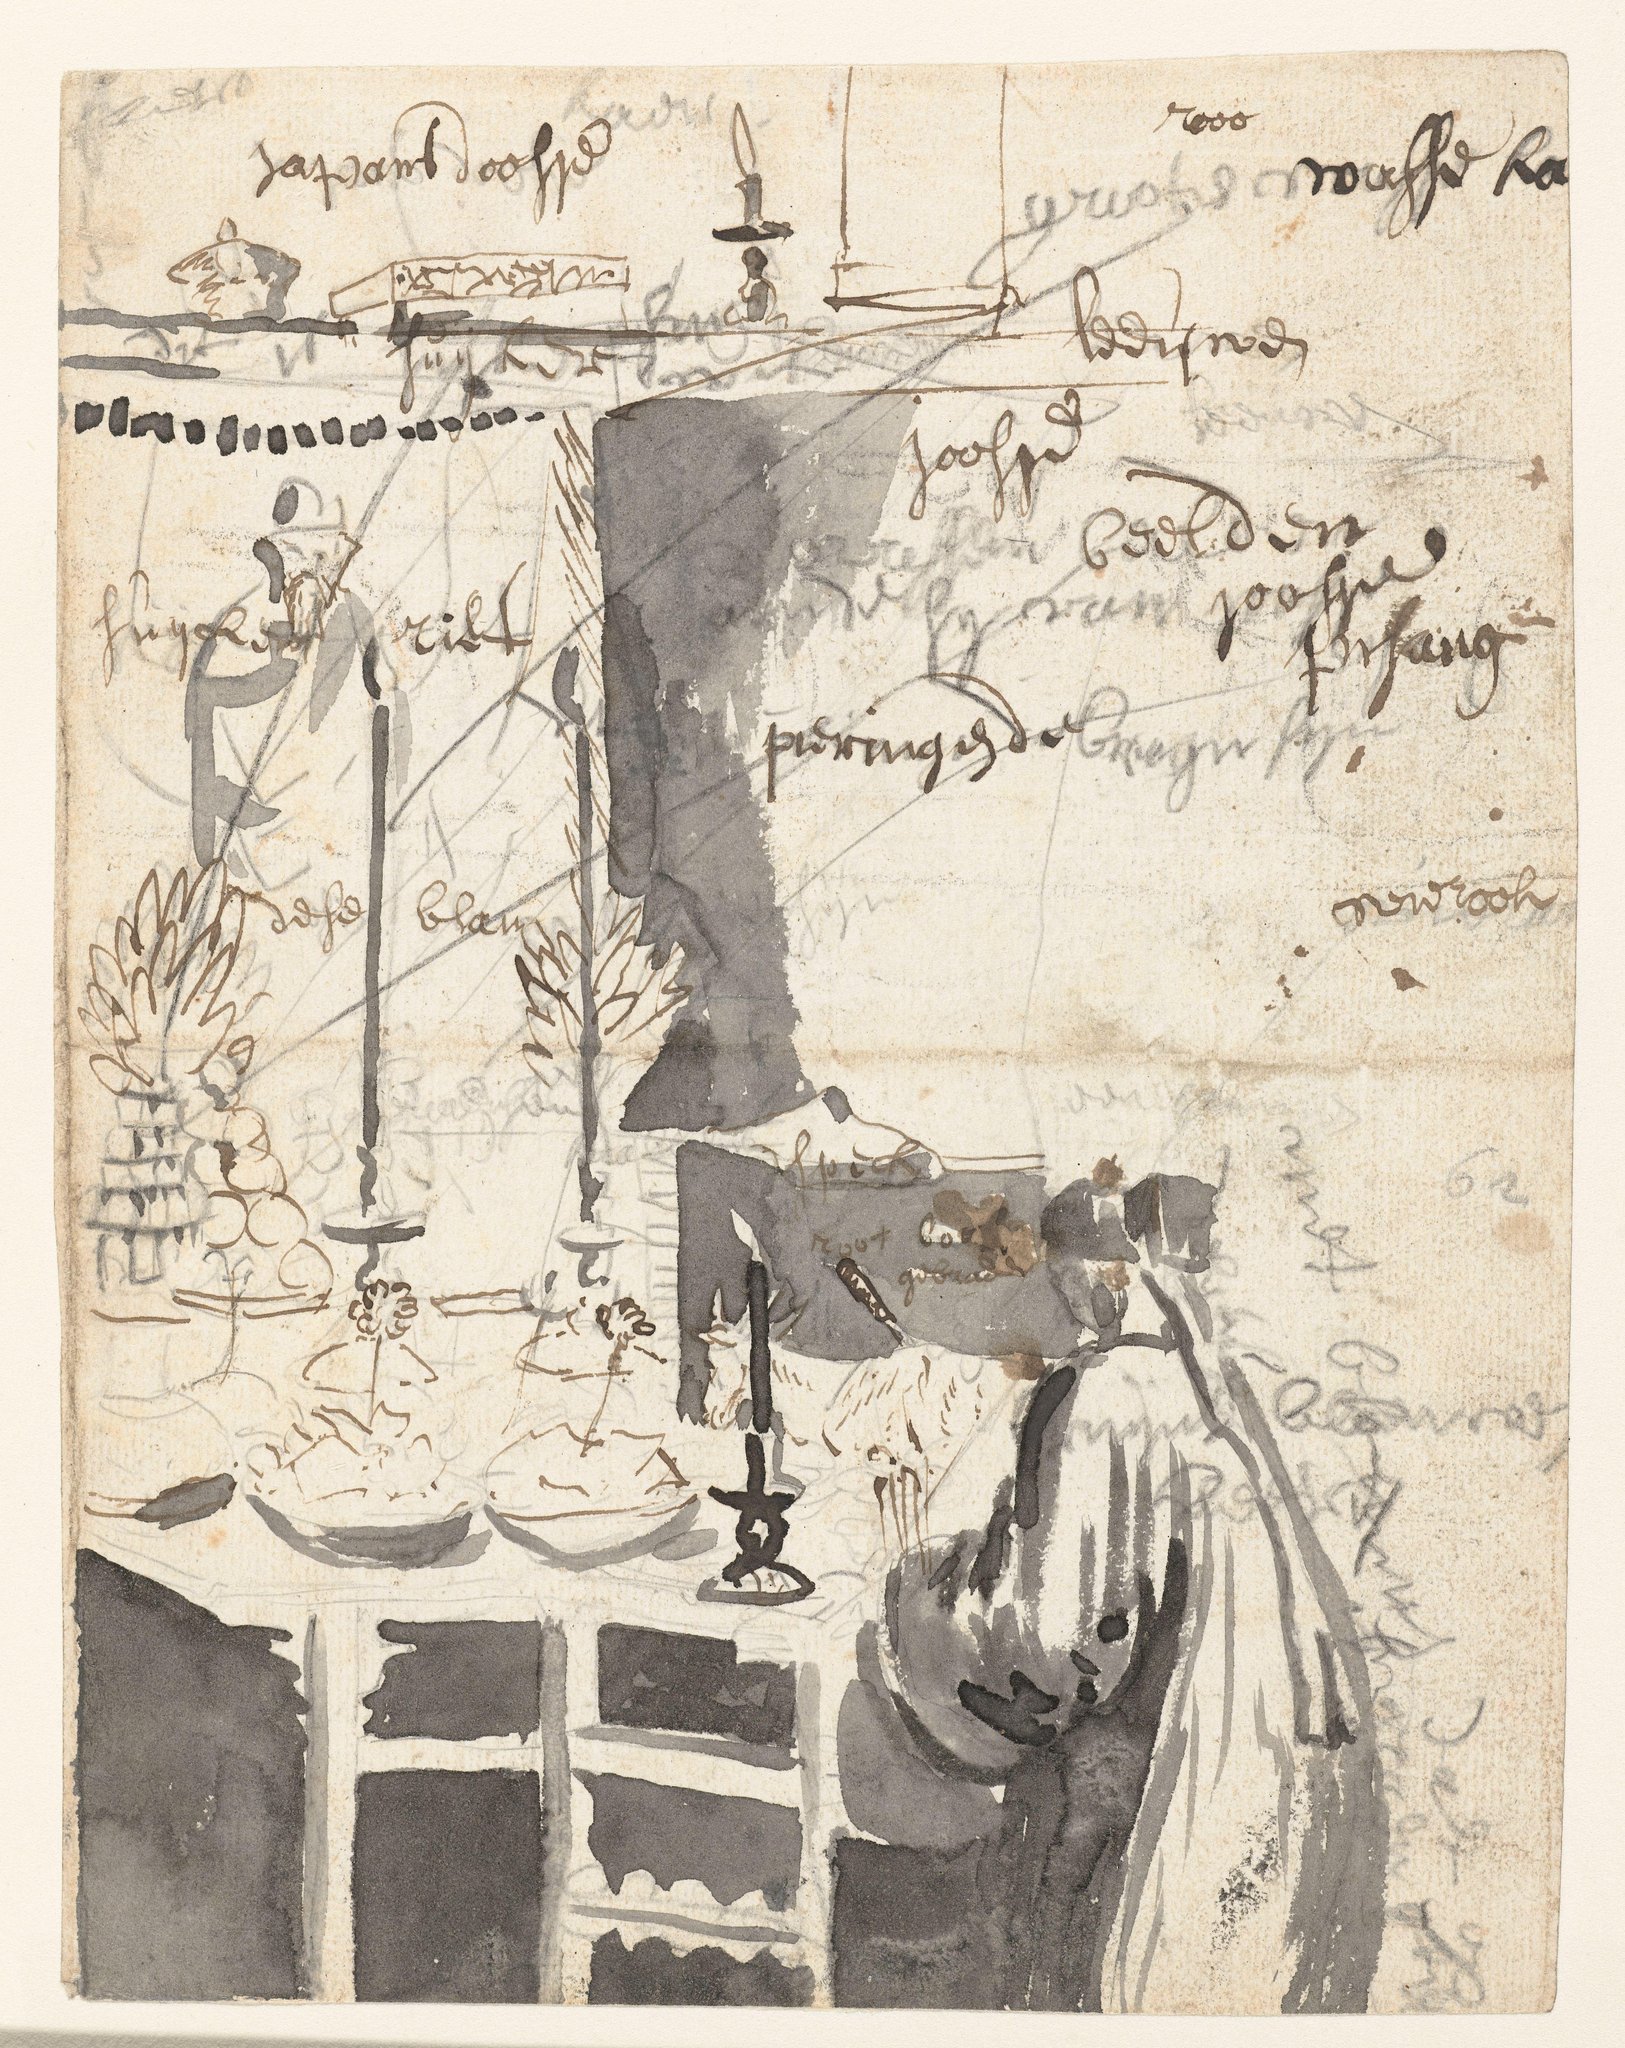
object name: drawing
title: Chinese man making an offering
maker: wouter schouten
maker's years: 1638-1704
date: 1660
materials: ink, paper, pencil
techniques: brush, drawing, pen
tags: dutch east indies, the